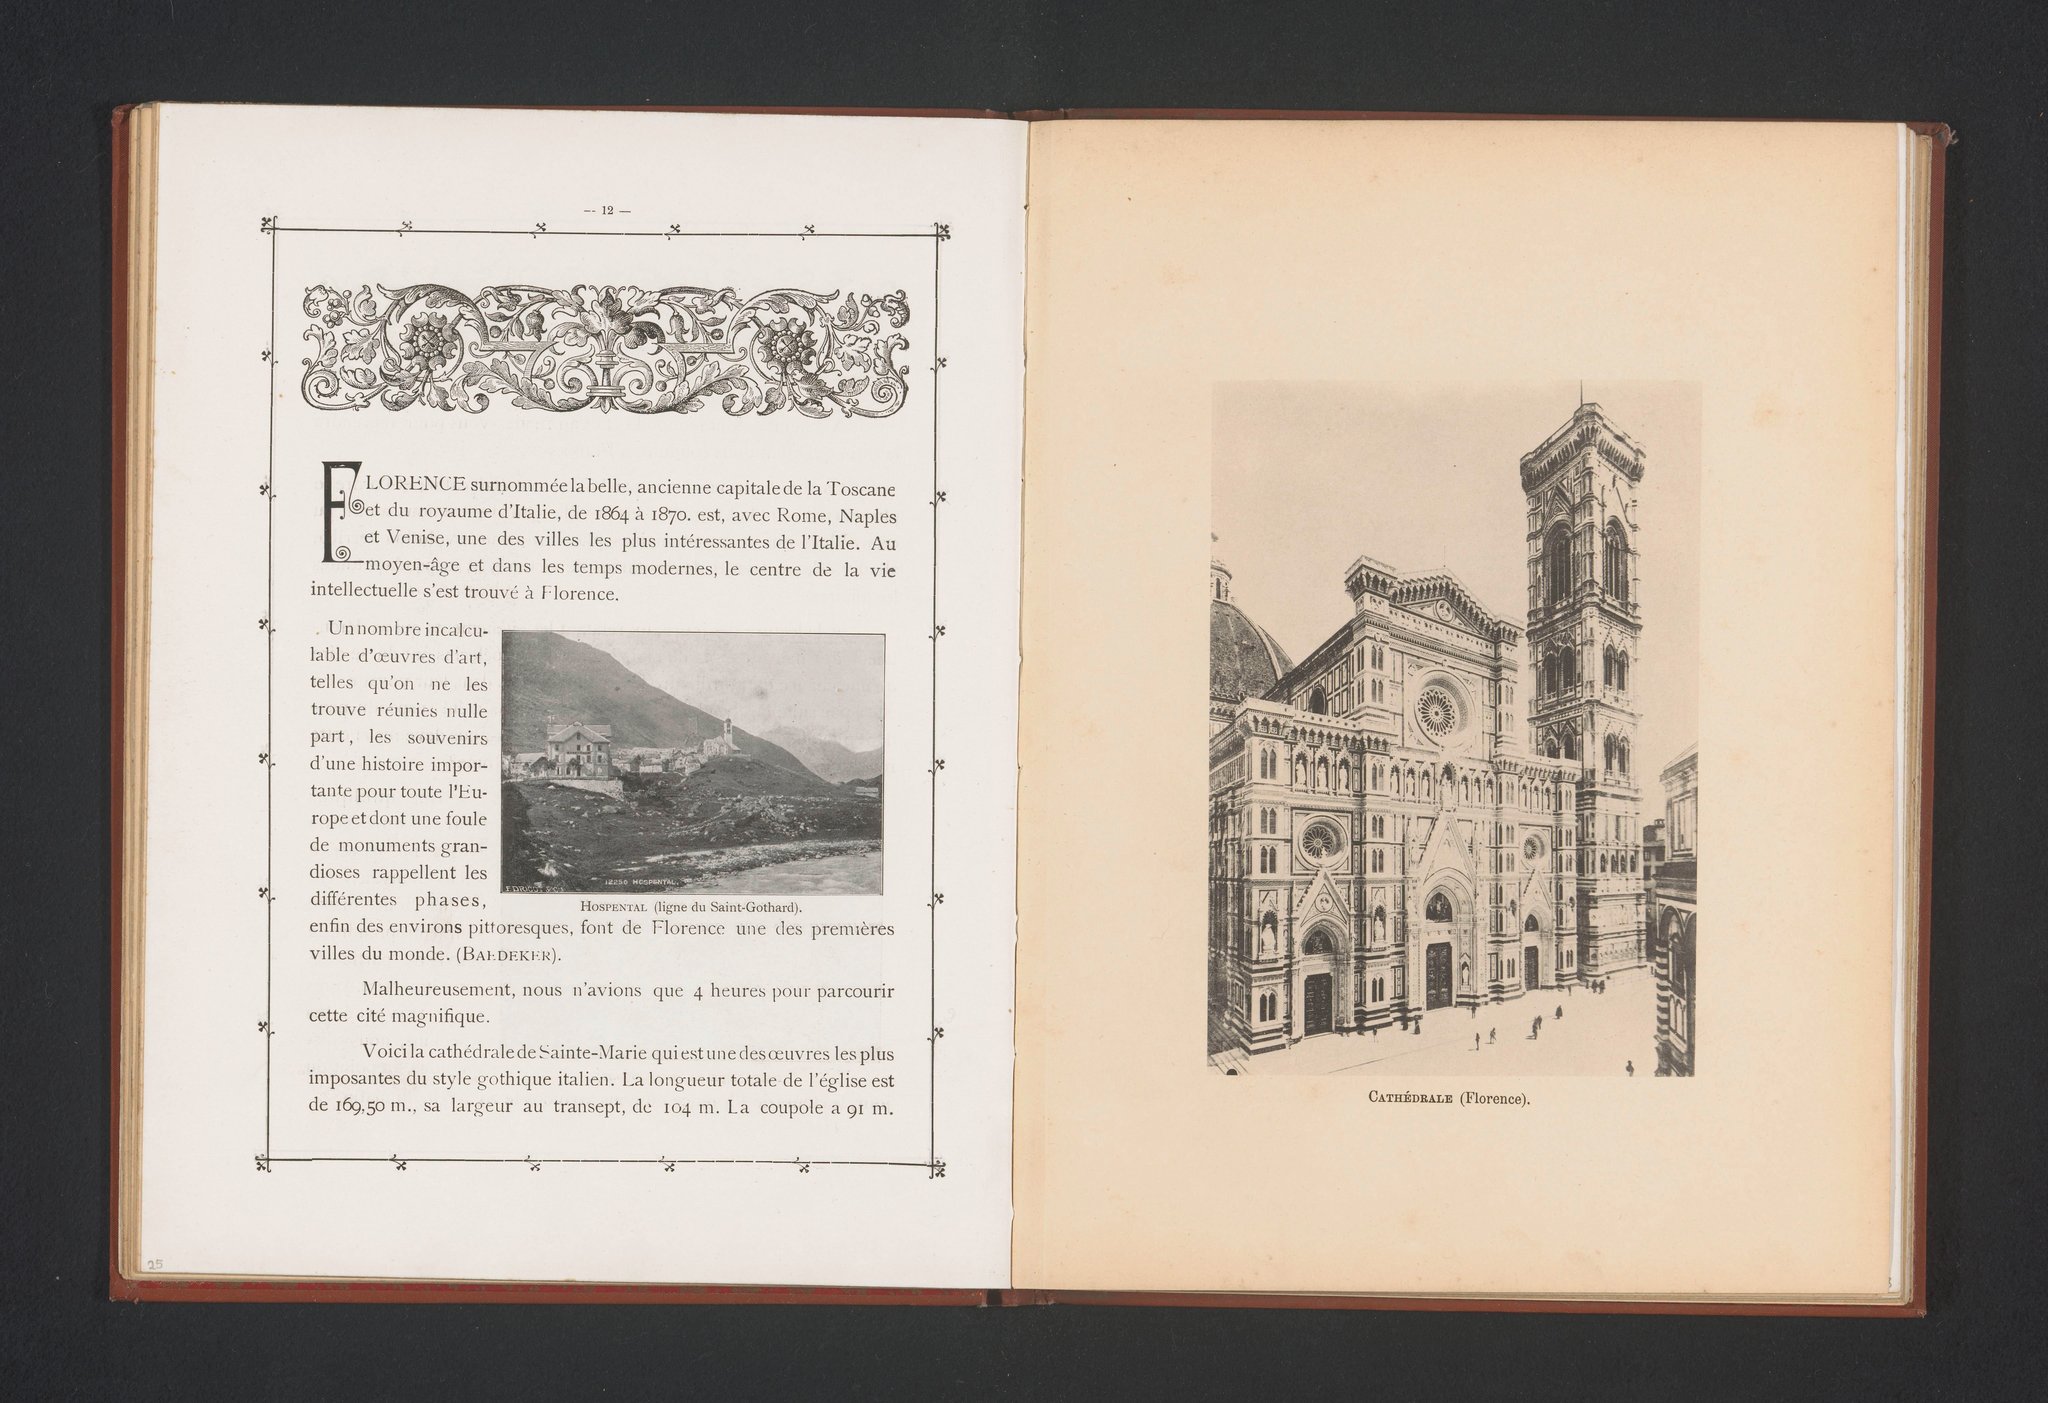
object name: page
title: Gezicht op de Gotthardpas bij Hospental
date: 1893-1898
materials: paper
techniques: autotype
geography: hospental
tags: prospect of village, silhouette of village, mountains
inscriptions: inscription: ‘12250 HOSPENTAL.’